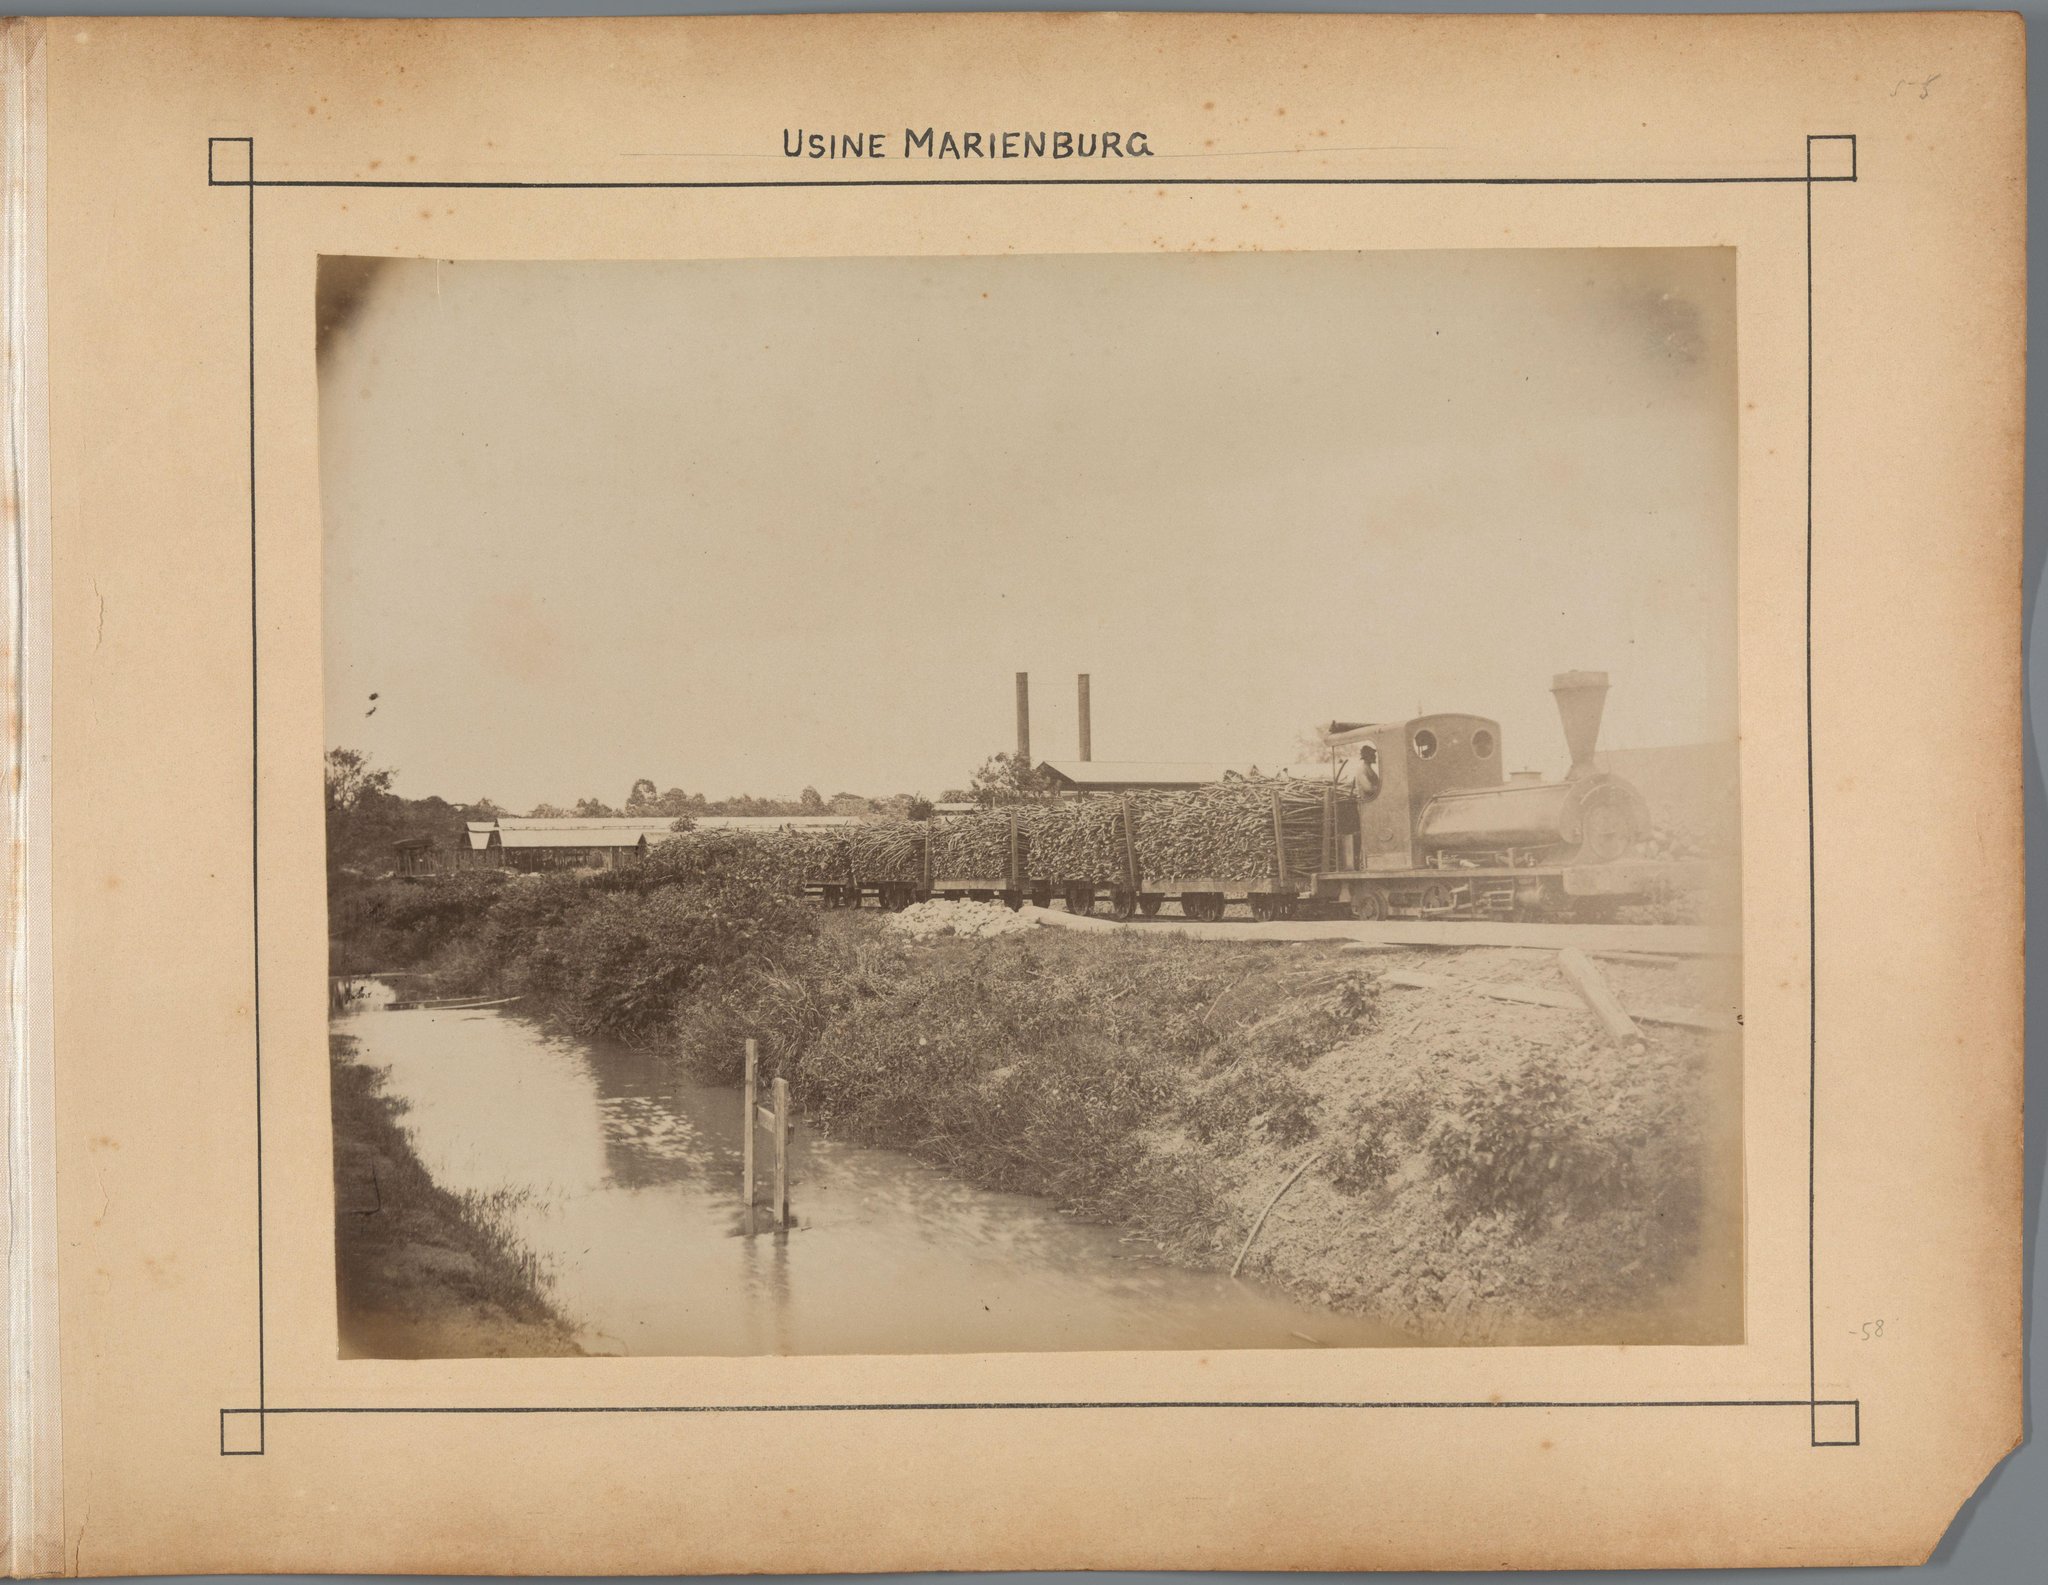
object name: photograph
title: Usine Marienburg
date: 1898-1902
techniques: albumen print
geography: suriname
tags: plantation, freight train, (non-fruit) products of plants or trees: sugarcane, suriname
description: Treintje om suikerriet te vervoeren op Plantage Marienburg.